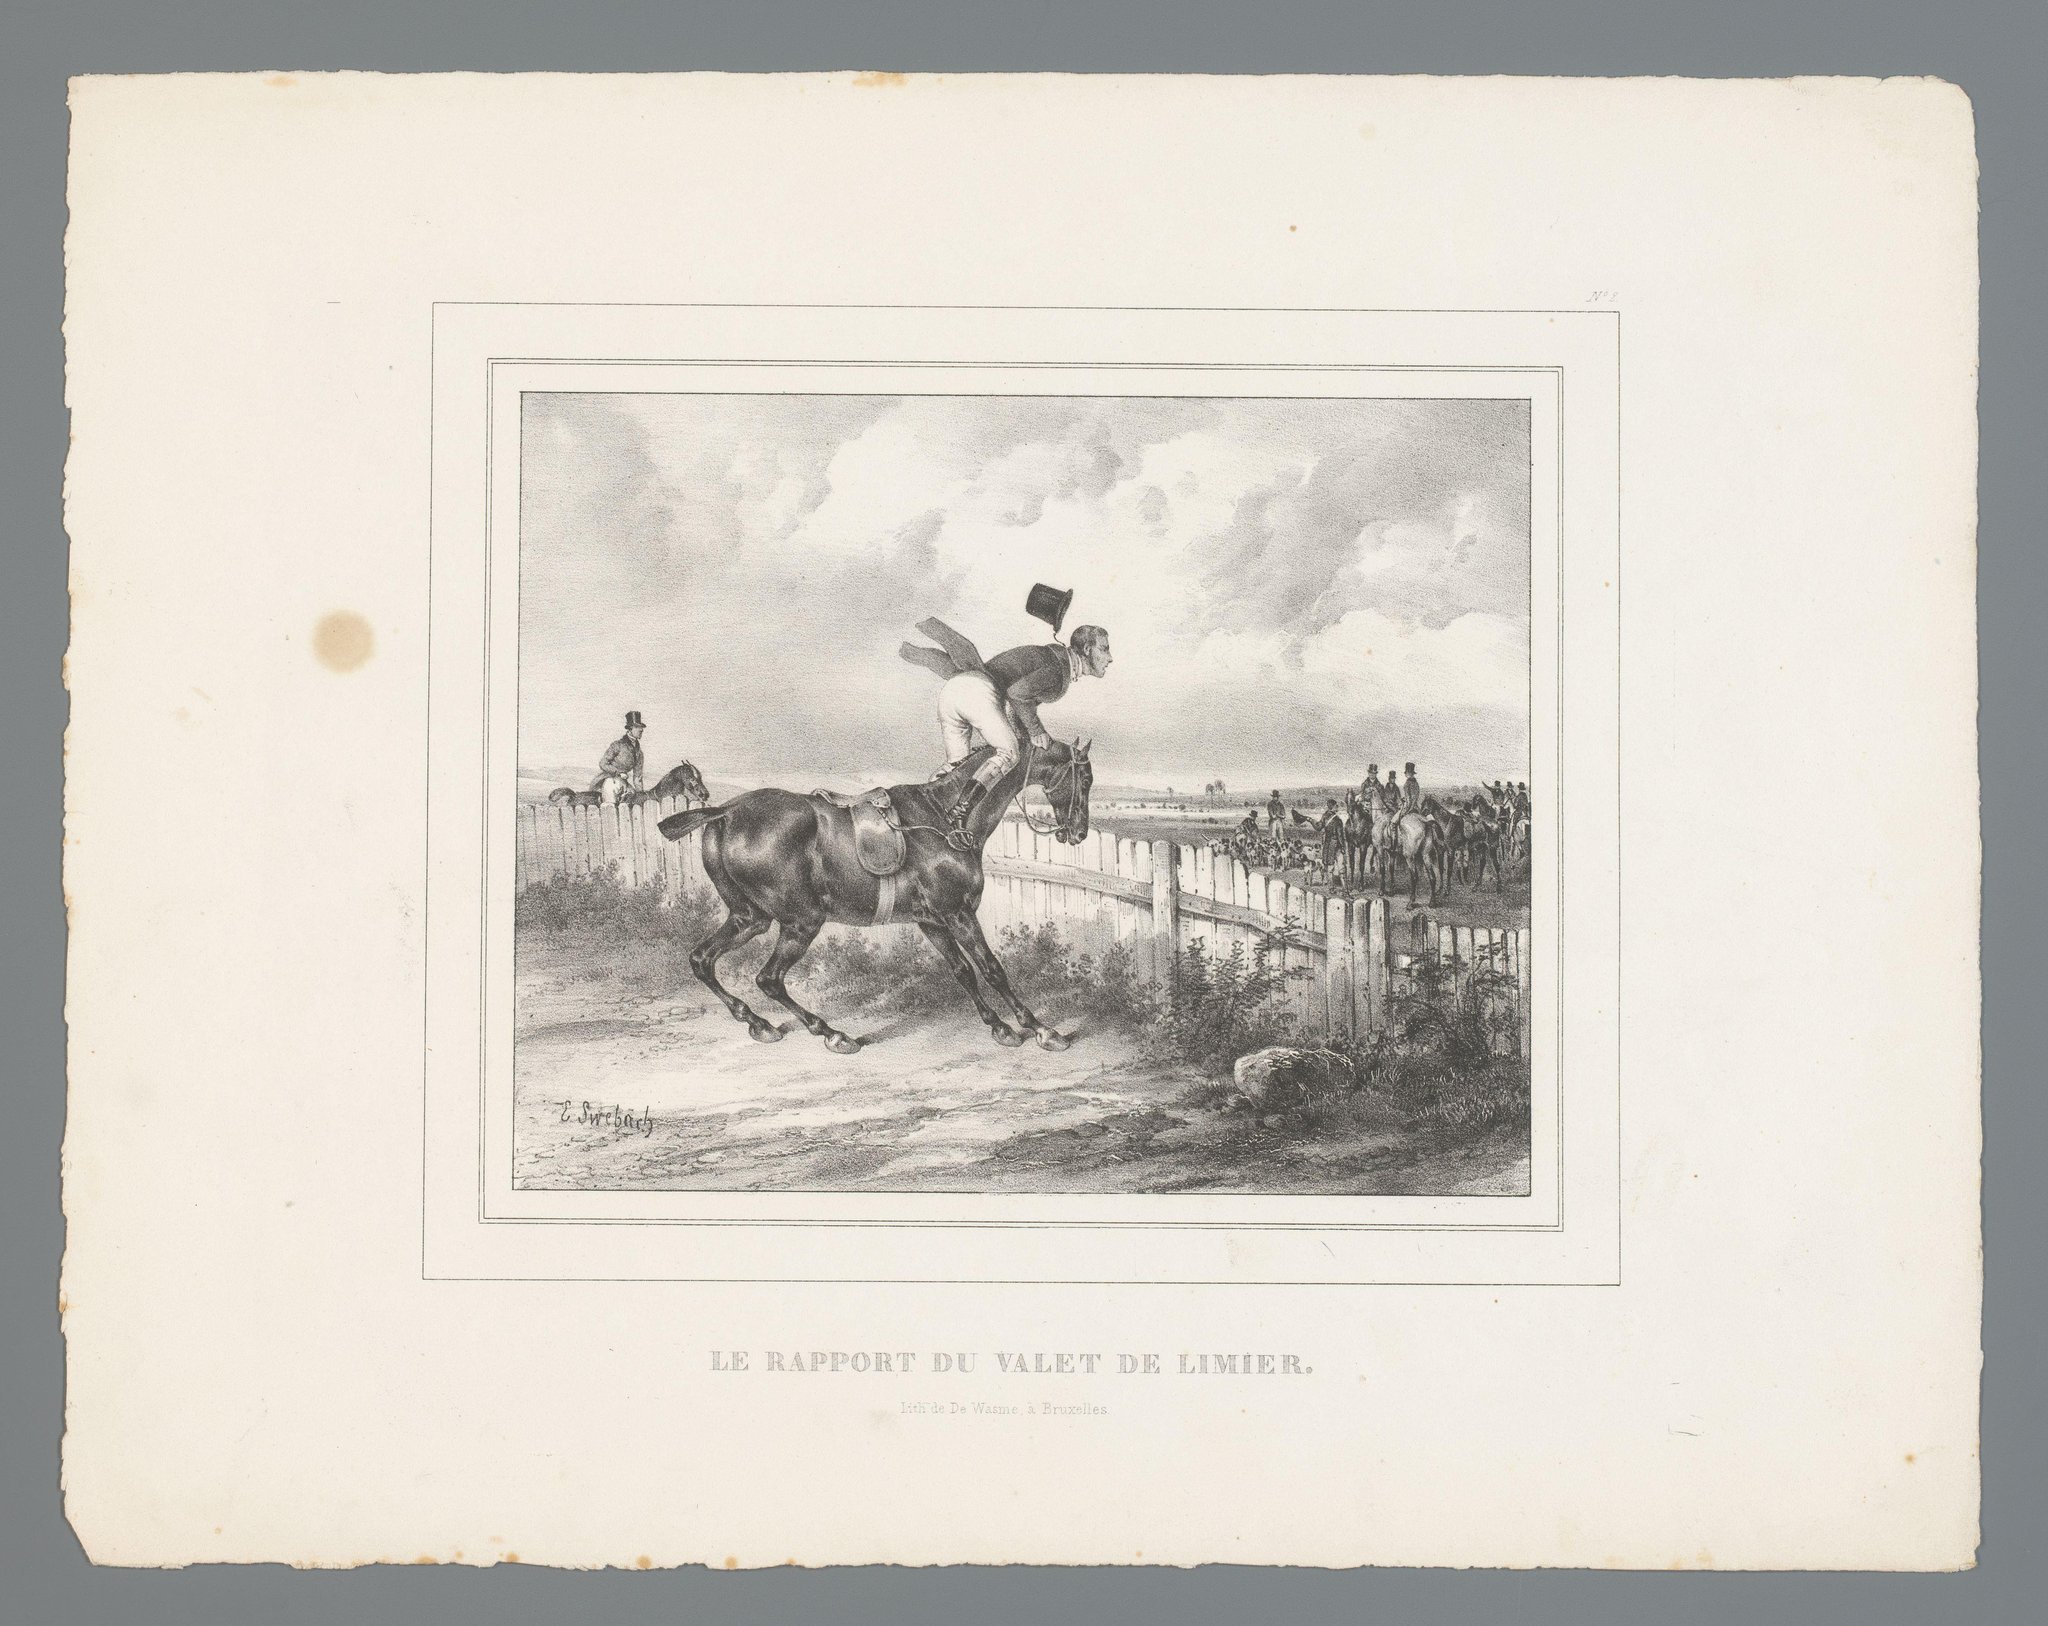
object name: cartoon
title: Man wordt van zijn paard geworpen bij een hek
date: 1825-1827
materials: paper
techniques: lithograph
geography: brussels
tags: hunting, chase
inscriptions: collector's mark: Lugt 2228